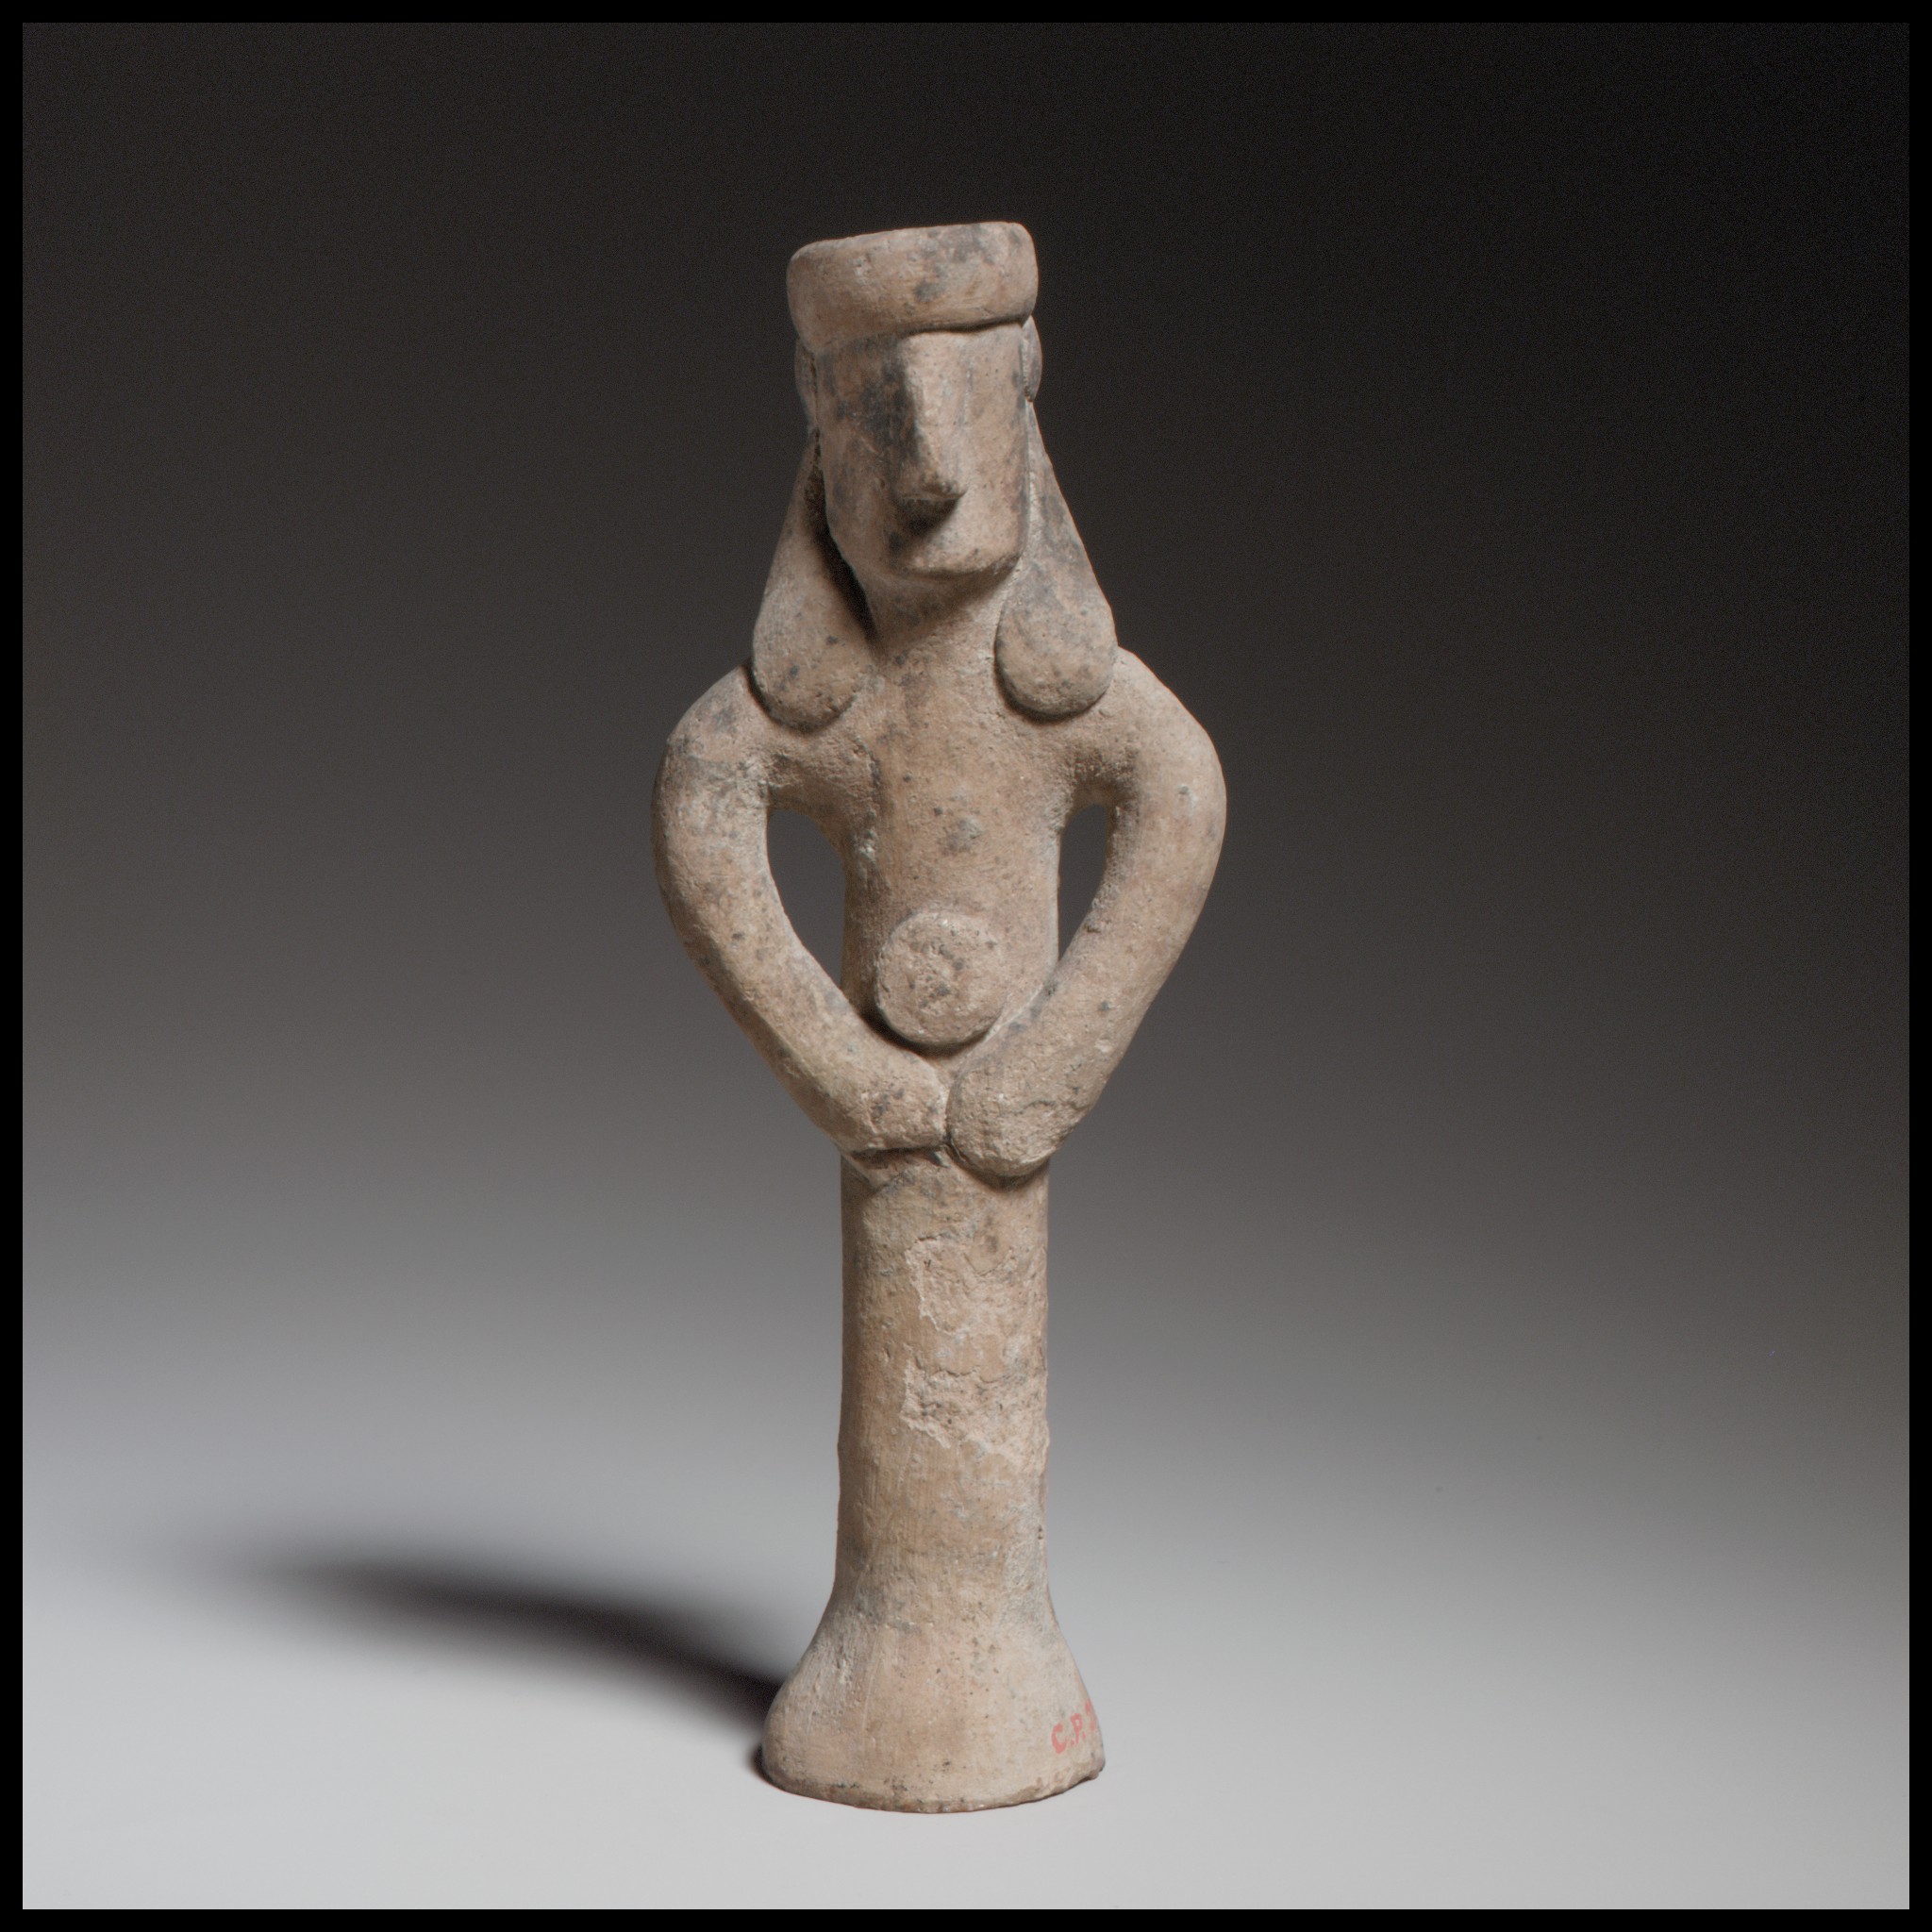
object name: statuette of a woman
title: Standing figure holding a tambourine(?)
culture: cypriot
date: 600-480 BCE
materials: terracotta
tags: musical instruments